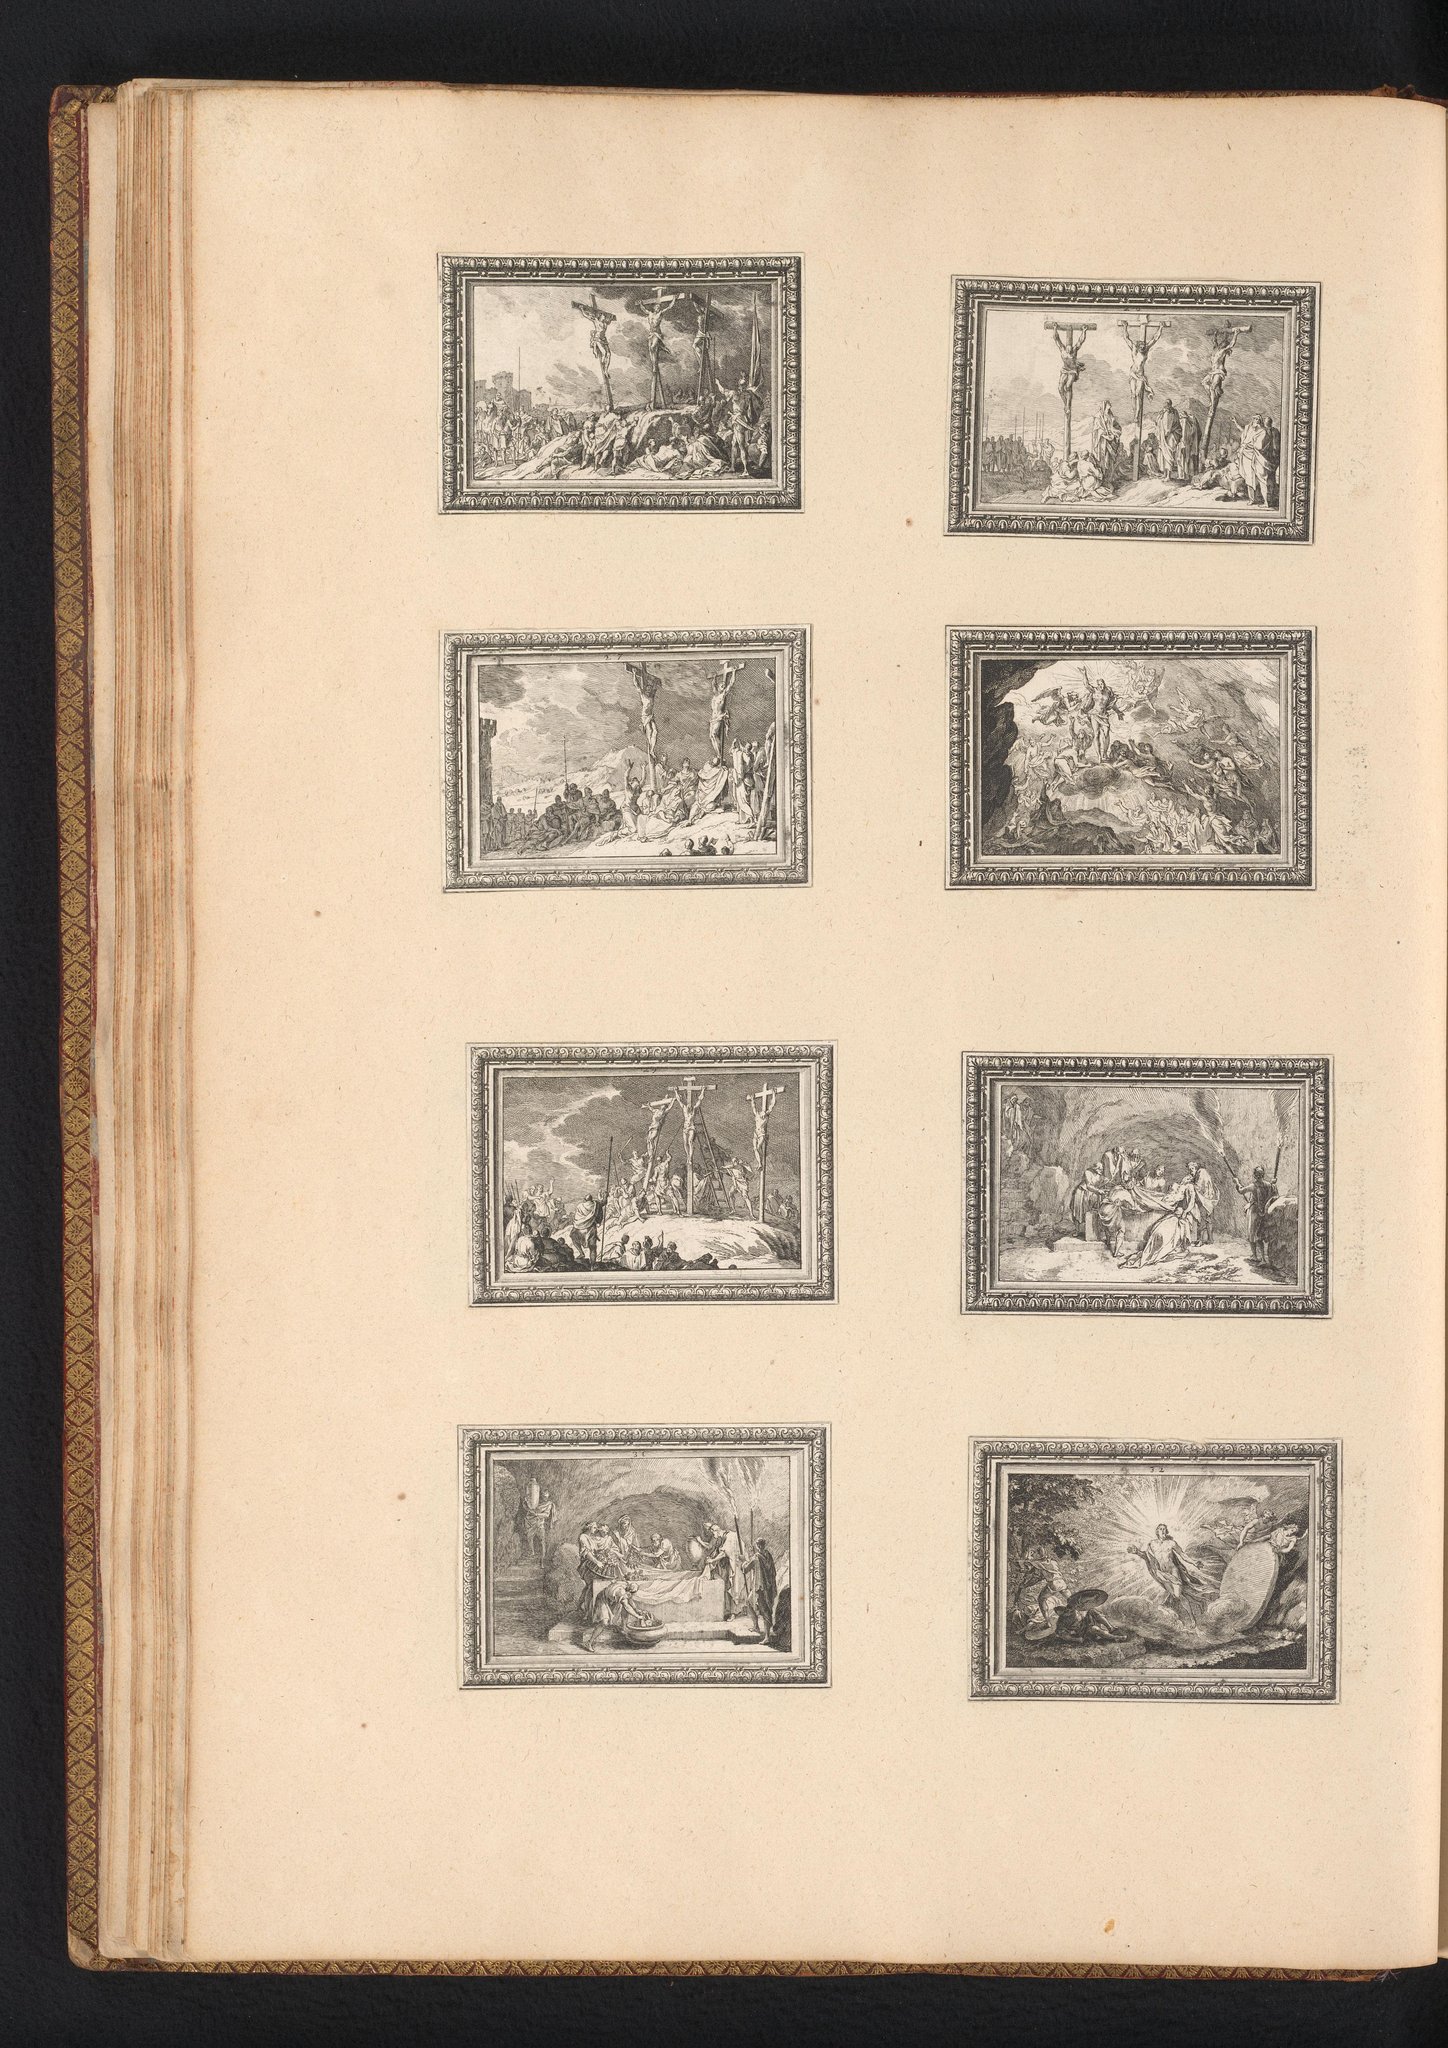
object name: print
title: Voorstellingen van de Passie van Christus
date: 1647-1703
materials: paper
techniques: engraving, etching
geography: paris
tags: passion of christ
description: Deze prenten maken deel uit van een serie met 36 voorstellingen van de Passie, opgedragen aan Madame de Maintenon. In het album bevinden zich verschillende staten van de serie: latere staten met de ornamentele lijst en eerdere staten zonder de ornamentele lijst.